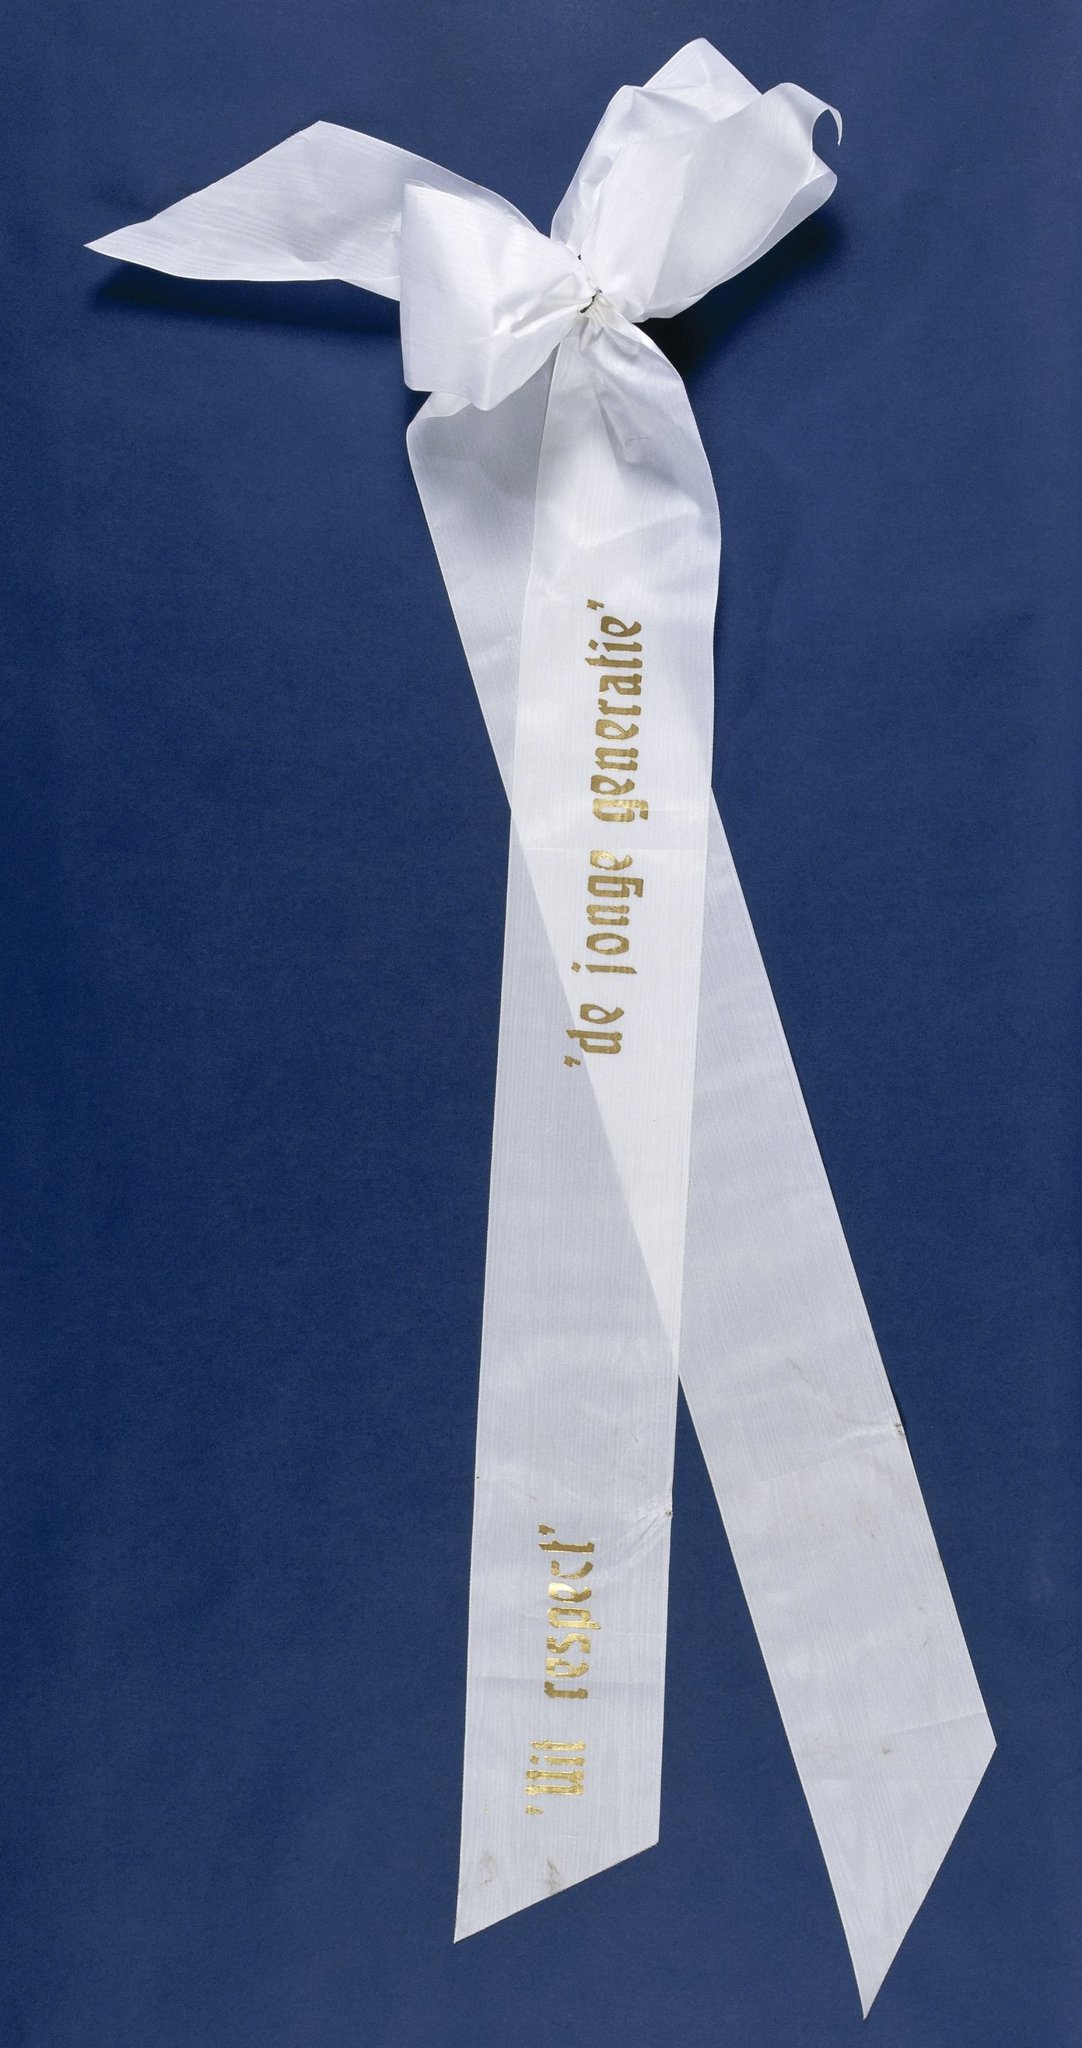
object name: ribbon material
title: Lint 'Uit respect - de jonge generatie'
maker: Anonymous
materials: gold leaf, textile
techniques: printing, weave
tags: amsterdam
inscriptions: inscription: ‘'Uit respect' 'de jonge generatie'’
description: Twee bij elkaar horende witte linten, gelegd op 4 mei 2000 bij het Nationaal Monument op de Dam. Het ene lint is v.z.v. een gouden opdruk, de andere is blanco. Linten zijn aan de uiteinden schuin afgeknipt. Aan een zijde tot strik gebonden met ijzerdraad. IJzerdraad gebogen t.b.v. bevestiging aan krans.